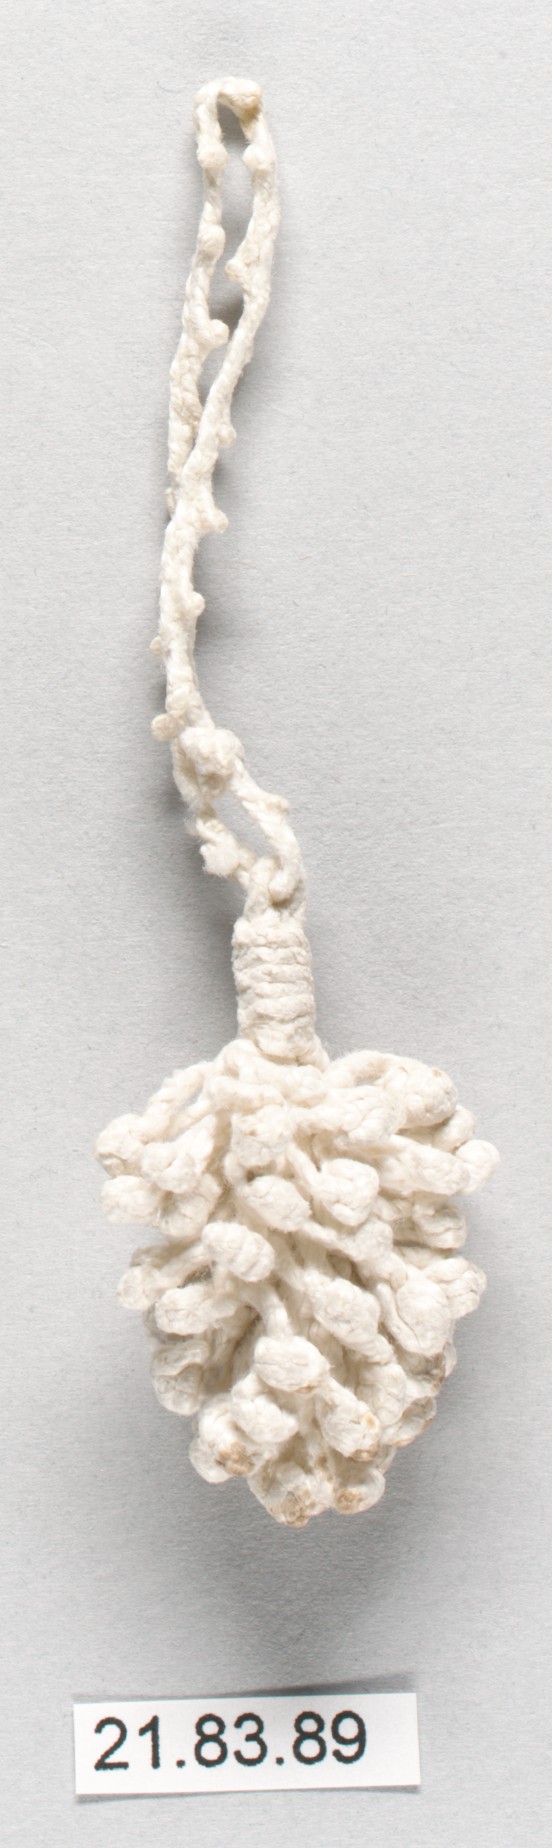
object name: tassel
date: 1601-1700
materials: linen